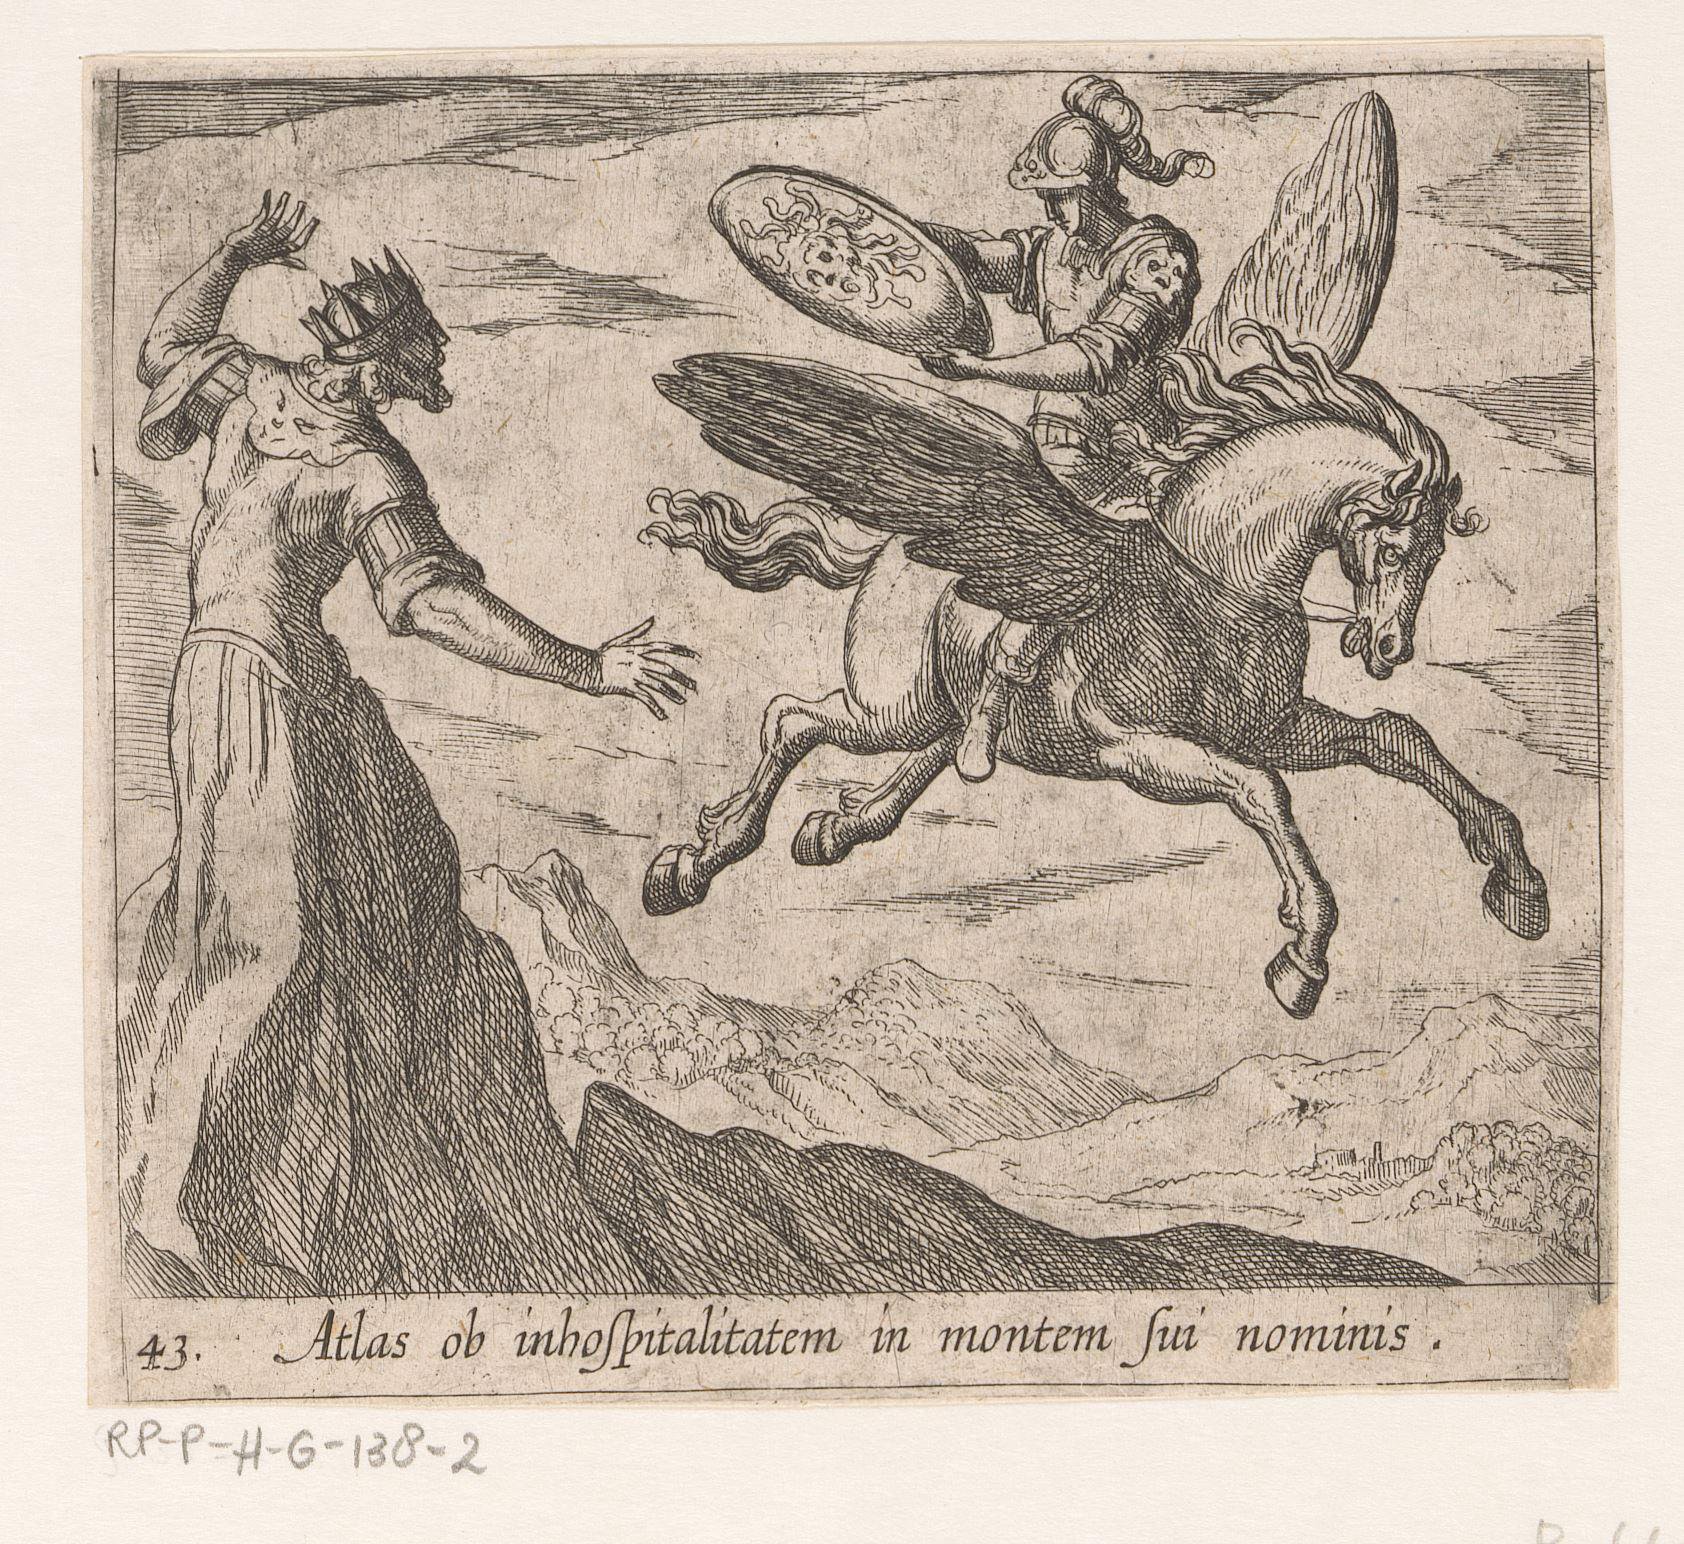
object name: print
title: Metamorphoseon sive transformationum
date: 1606-1638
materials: paper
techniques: etching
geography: amsterdam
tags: atlas turned into a mountain as punishment for his inhospitality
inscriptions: collector's mark: ‘Hinloopen’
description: Deze prent maakt deel uit van een reeks van 150 prenten (+ titelprent) met voorstellingen van de Metamorfosen van Ovidius.